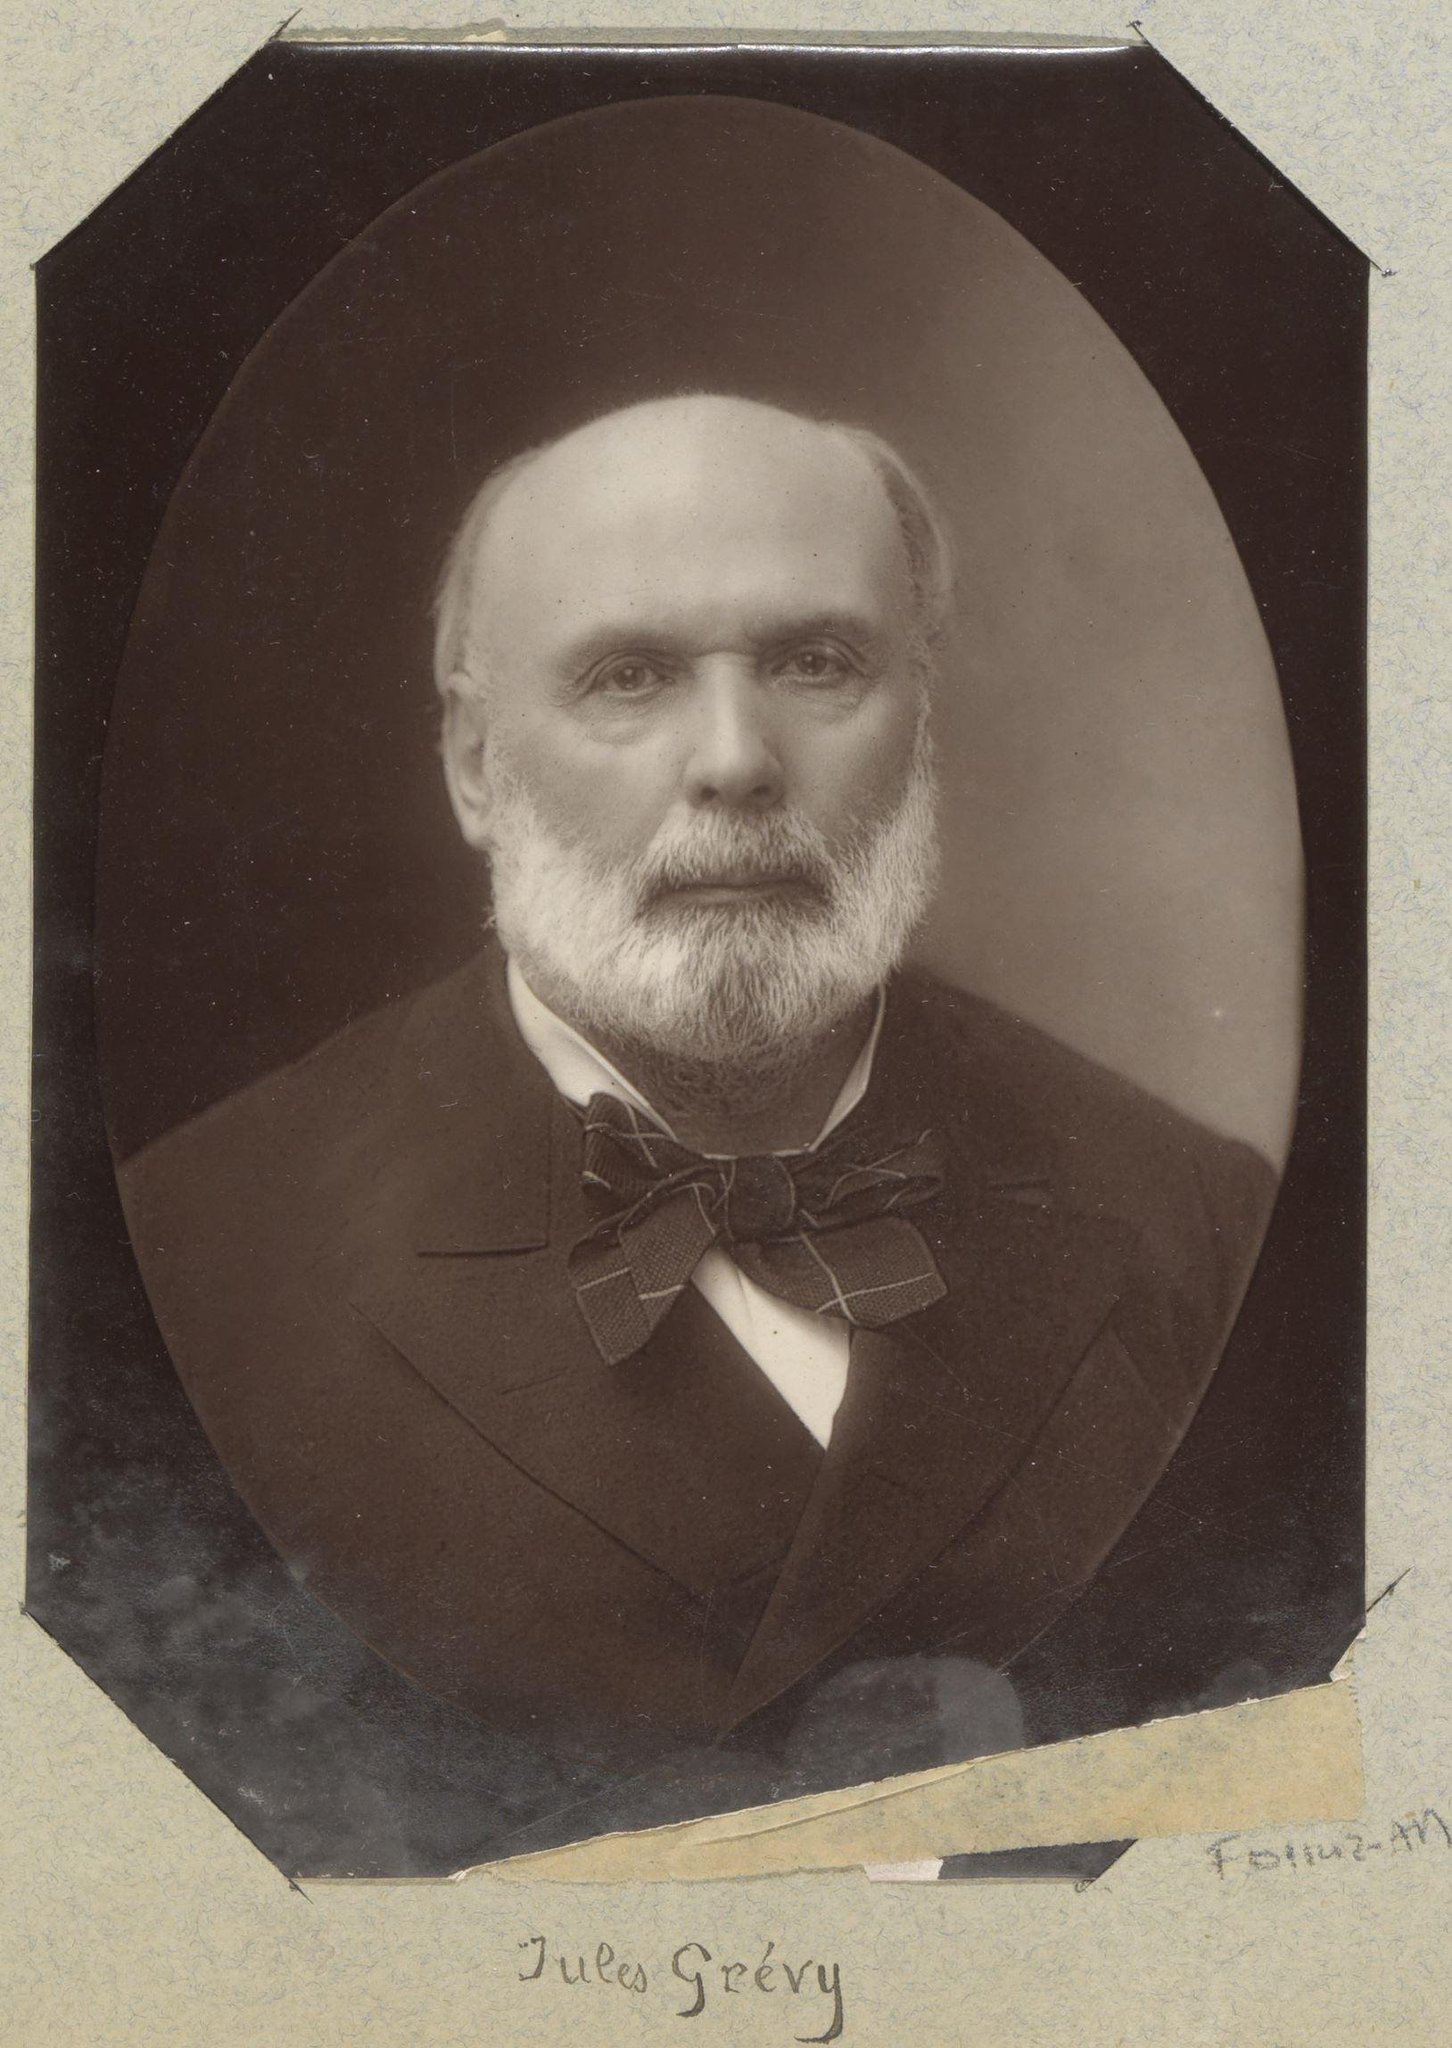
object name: album leaf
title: Portret van Jules Grévy, president van Frankrijk (1879-1887)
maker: Anonymous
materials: paper, photographic support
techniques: carbon print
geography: france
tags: president ~ head of republic, france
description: Onderdeel van Album van een Franse amateur met foto's van Frankrijk, Algerije, Palmyra, de Wereldtentoonstelling van 1900 en van bekende Fransen.